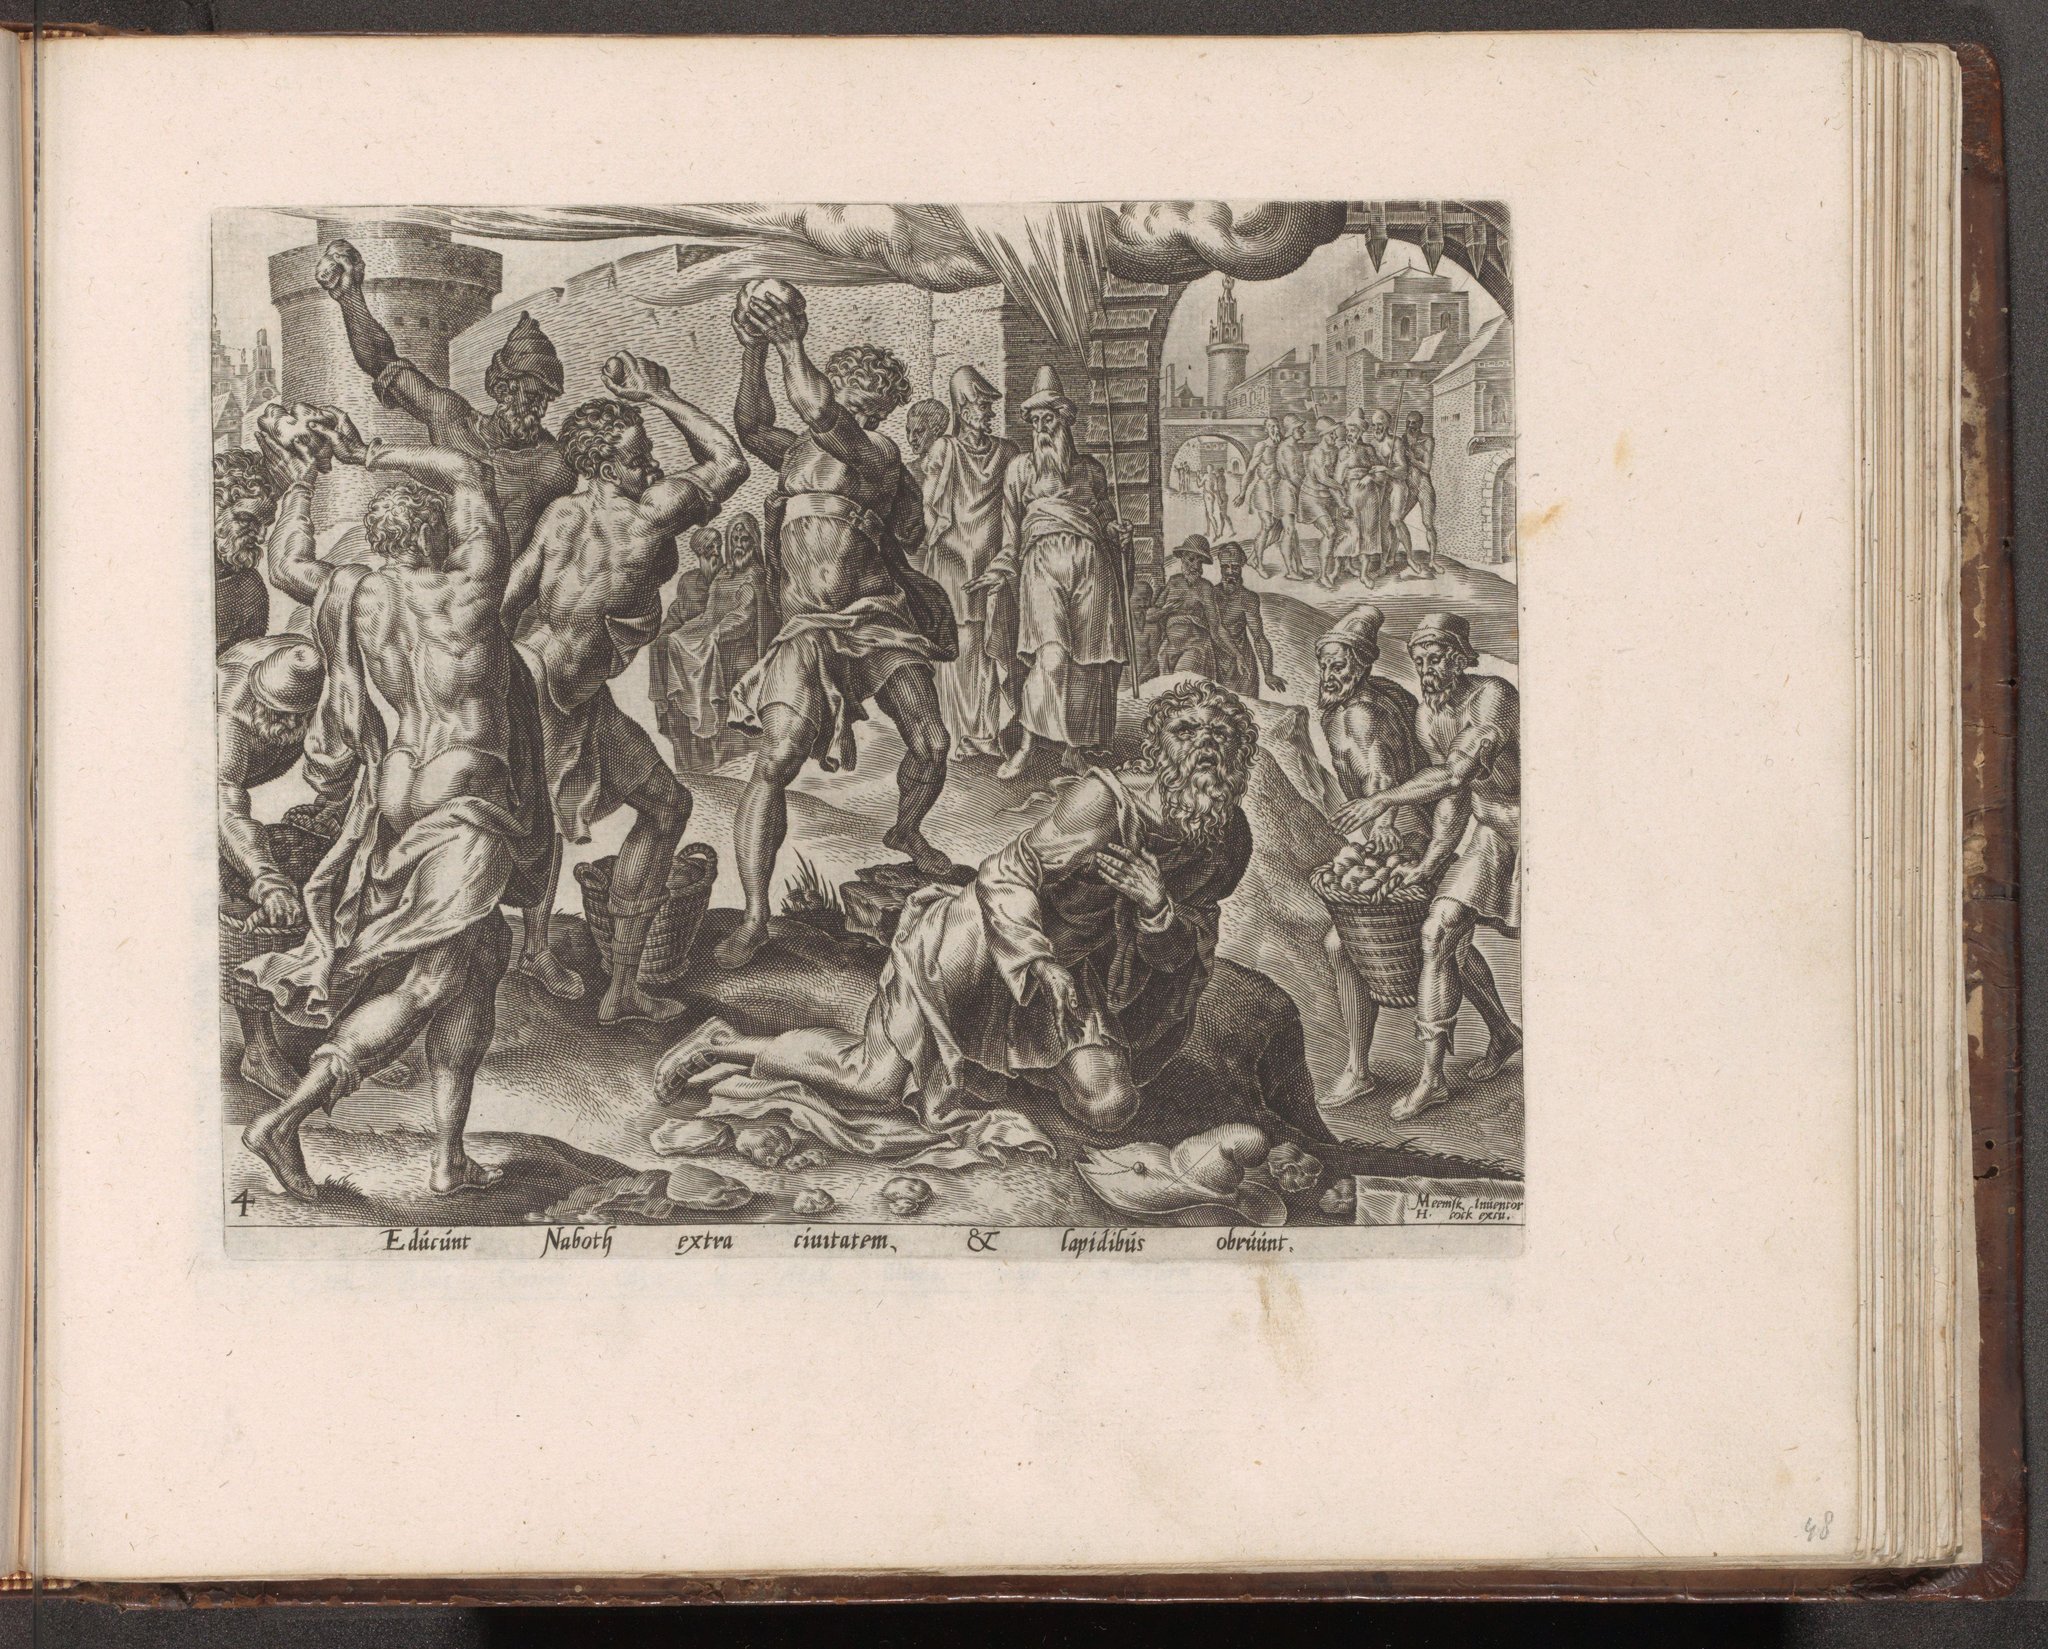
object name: album leaf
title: Geschiedenis van Achab, Izebel en Nabot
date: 1559-1563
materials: paper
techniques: engraving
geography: antwerp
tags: naboth is stoned to death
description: Voor de poorten van de stad wordt Nabot gestenigd. Hij knielt op de grond en jonge mannen bekogelen hem met stenen. Rechts arriveren twee mannen met een nieuwe mand met stenen. Door de stadspoort is te zien hoe Nabot gevangen genomen wordt. Onder de voorstelling een vers in het Latijn. Prent maakt deel uit van een album.